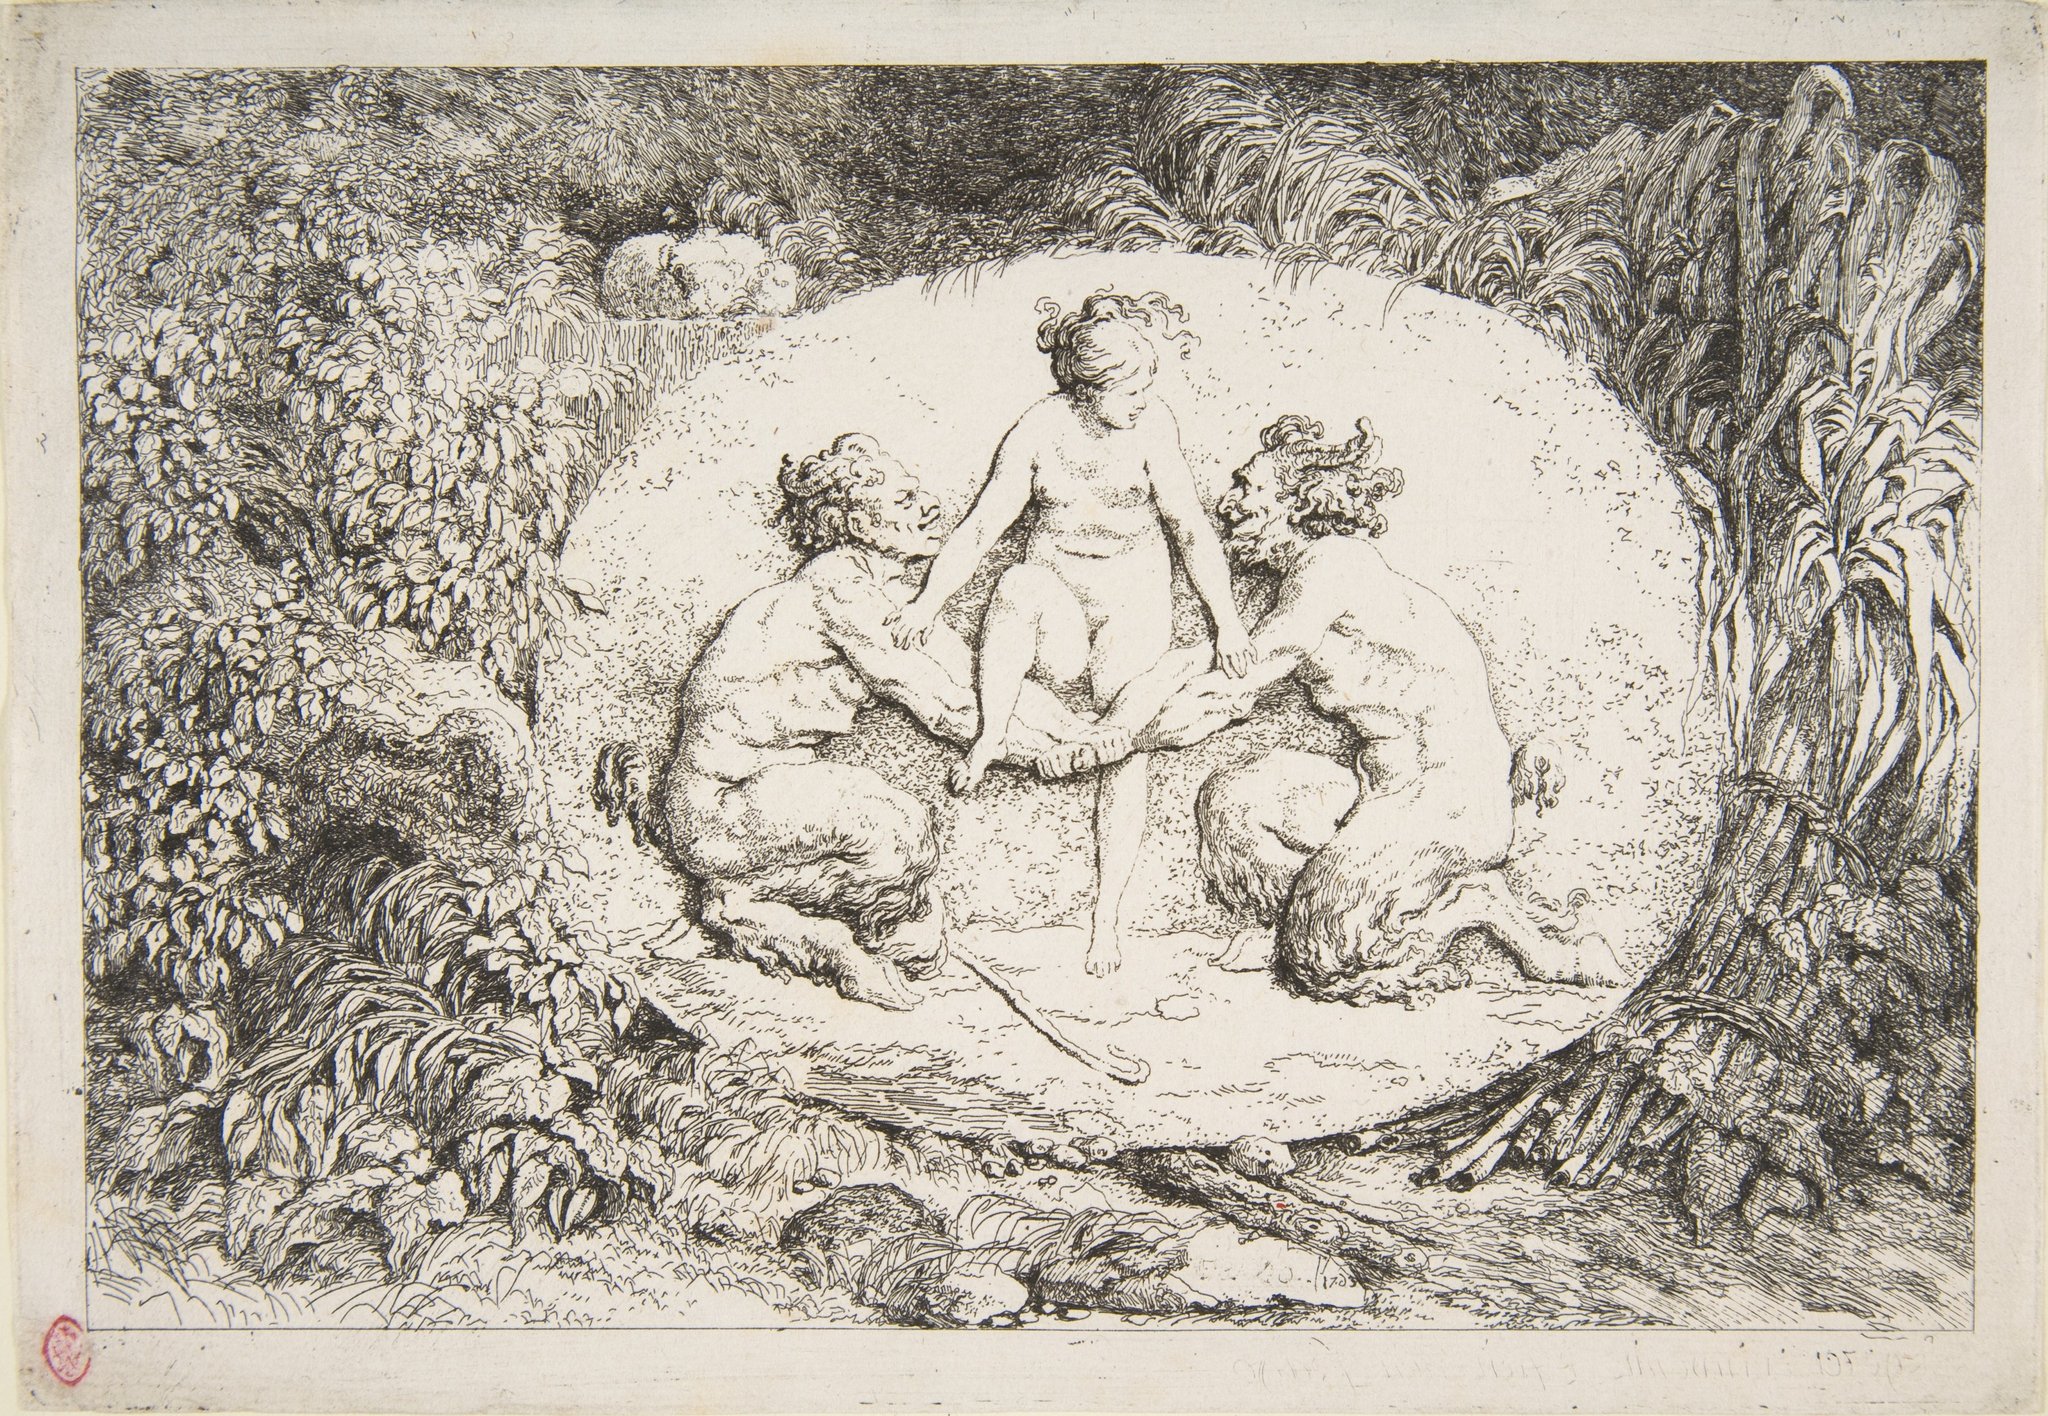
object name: print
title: Nymph Supported by Two Satyrs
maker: jean honoré fragonard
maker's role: artist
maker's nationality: french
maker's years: 1732-1806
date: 1763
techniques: etching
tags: nymphs,satyrs,rabbits,leaves